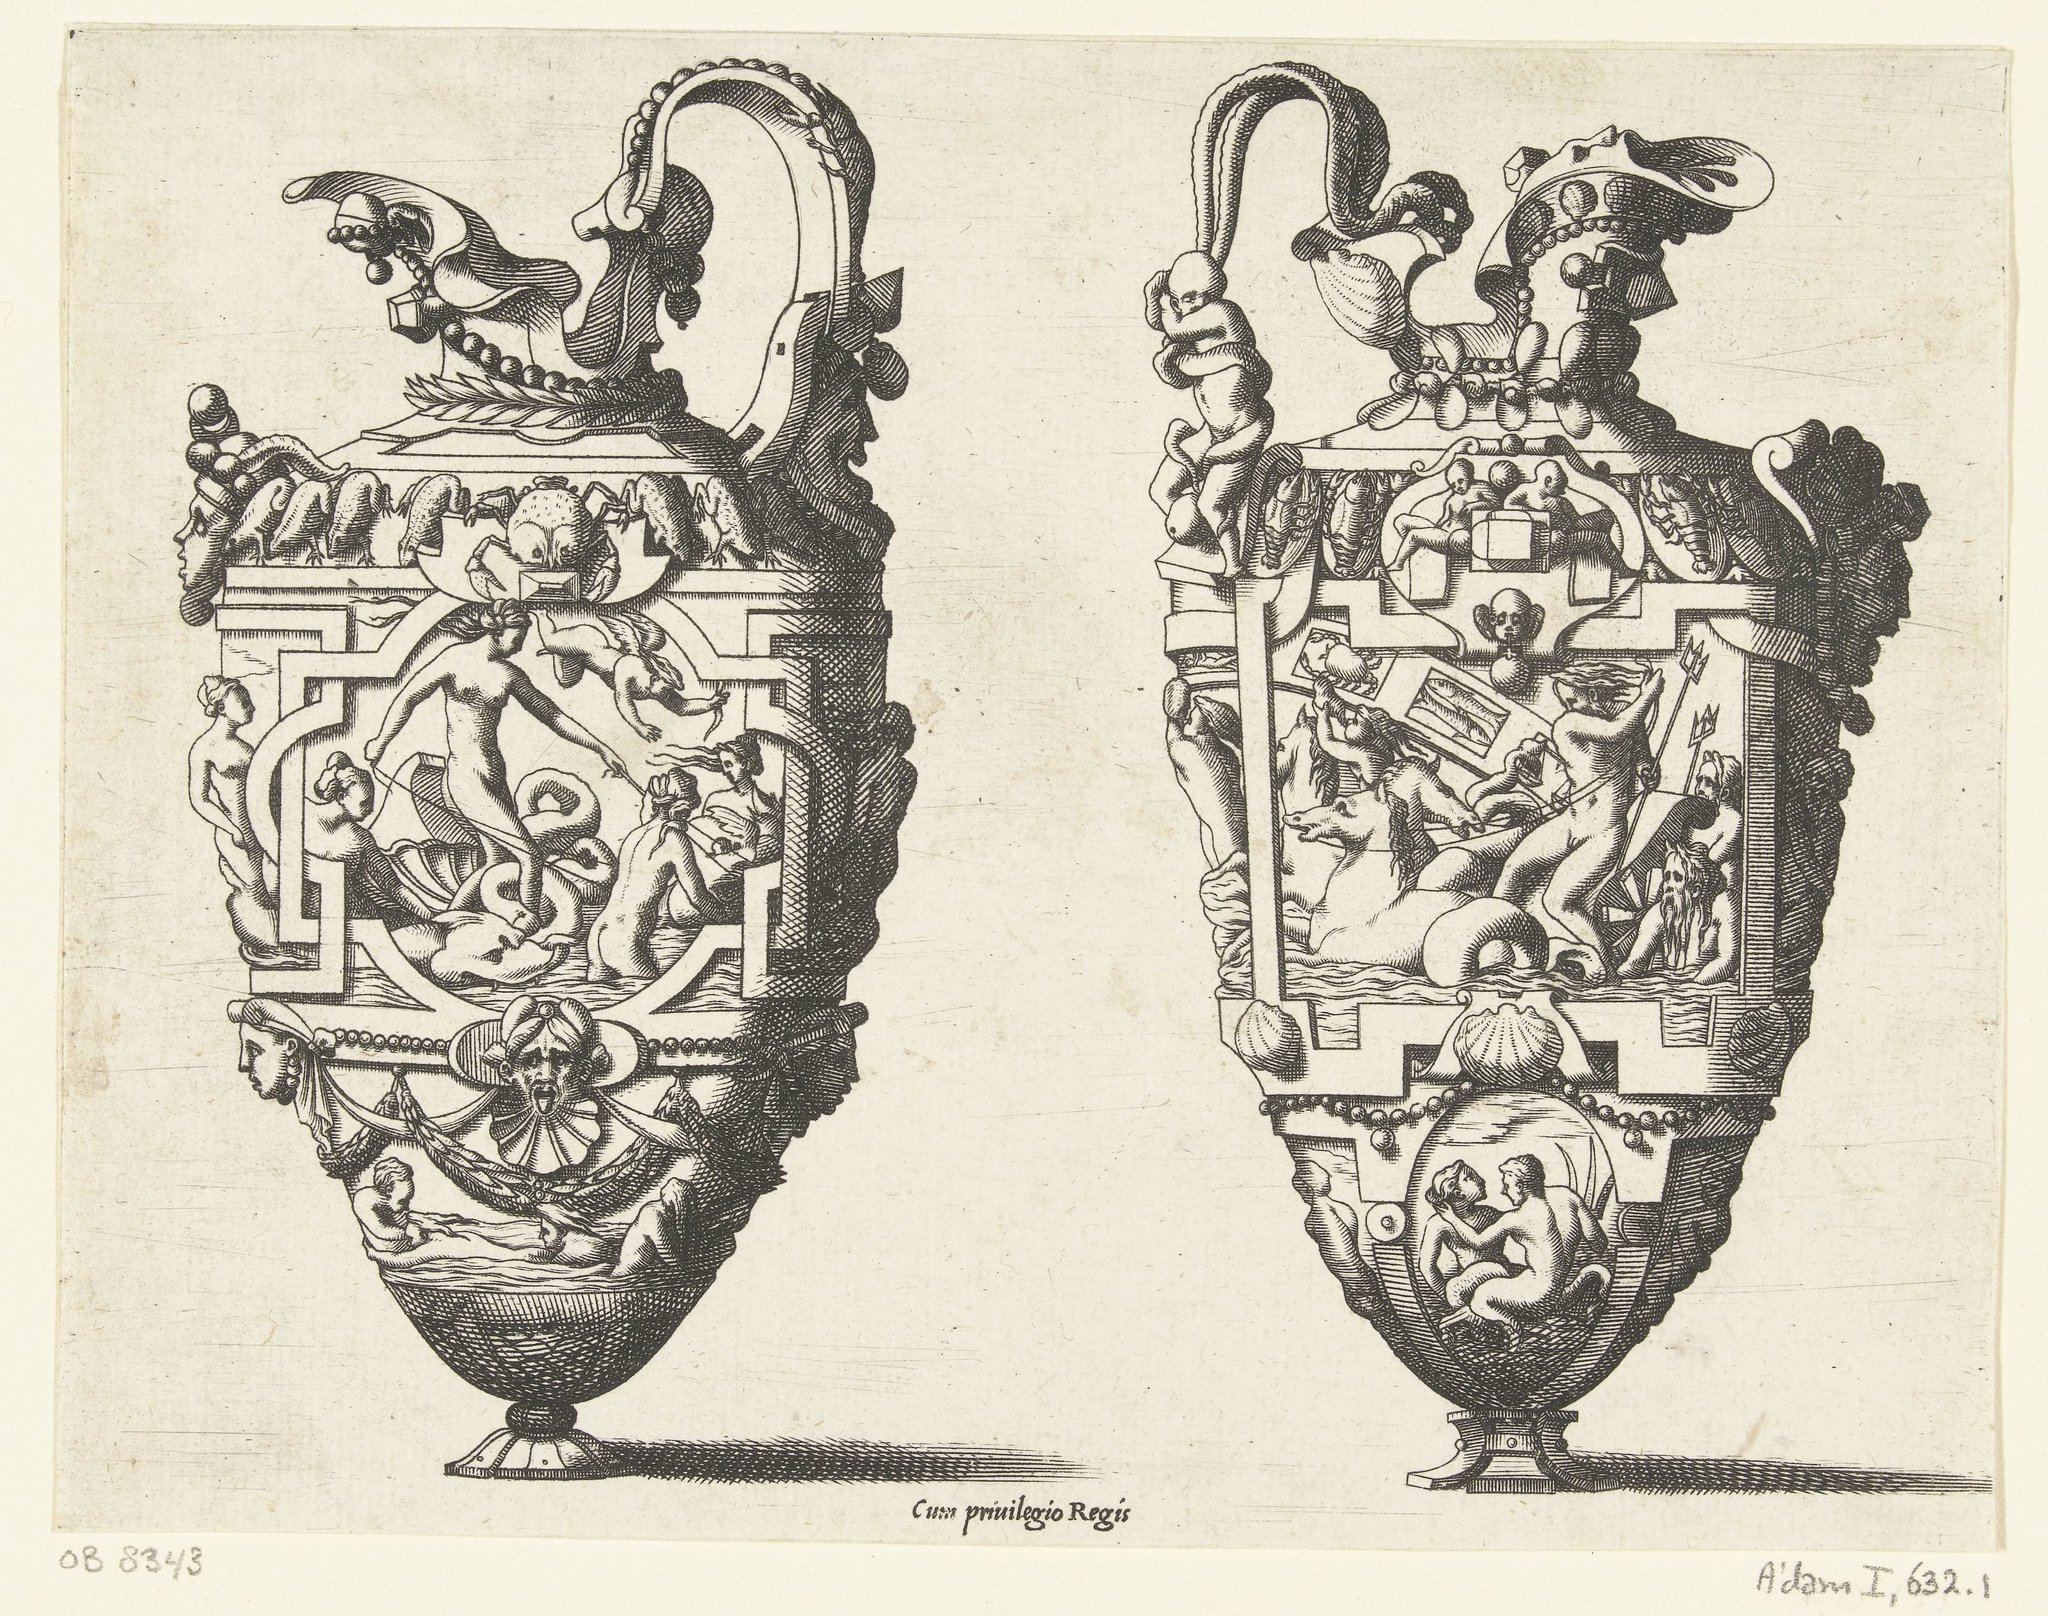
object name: print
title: Twee kannen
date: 1542-1580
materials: paper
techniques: engraving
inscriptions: collector's mark: Lugt 240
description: Op de buik van de linker kan bevindt zich een voorstelling van Venus die op een schelp over het water getrokken wordt. Op de buik van de rechter kan zit Neptunus op zijn wagen.